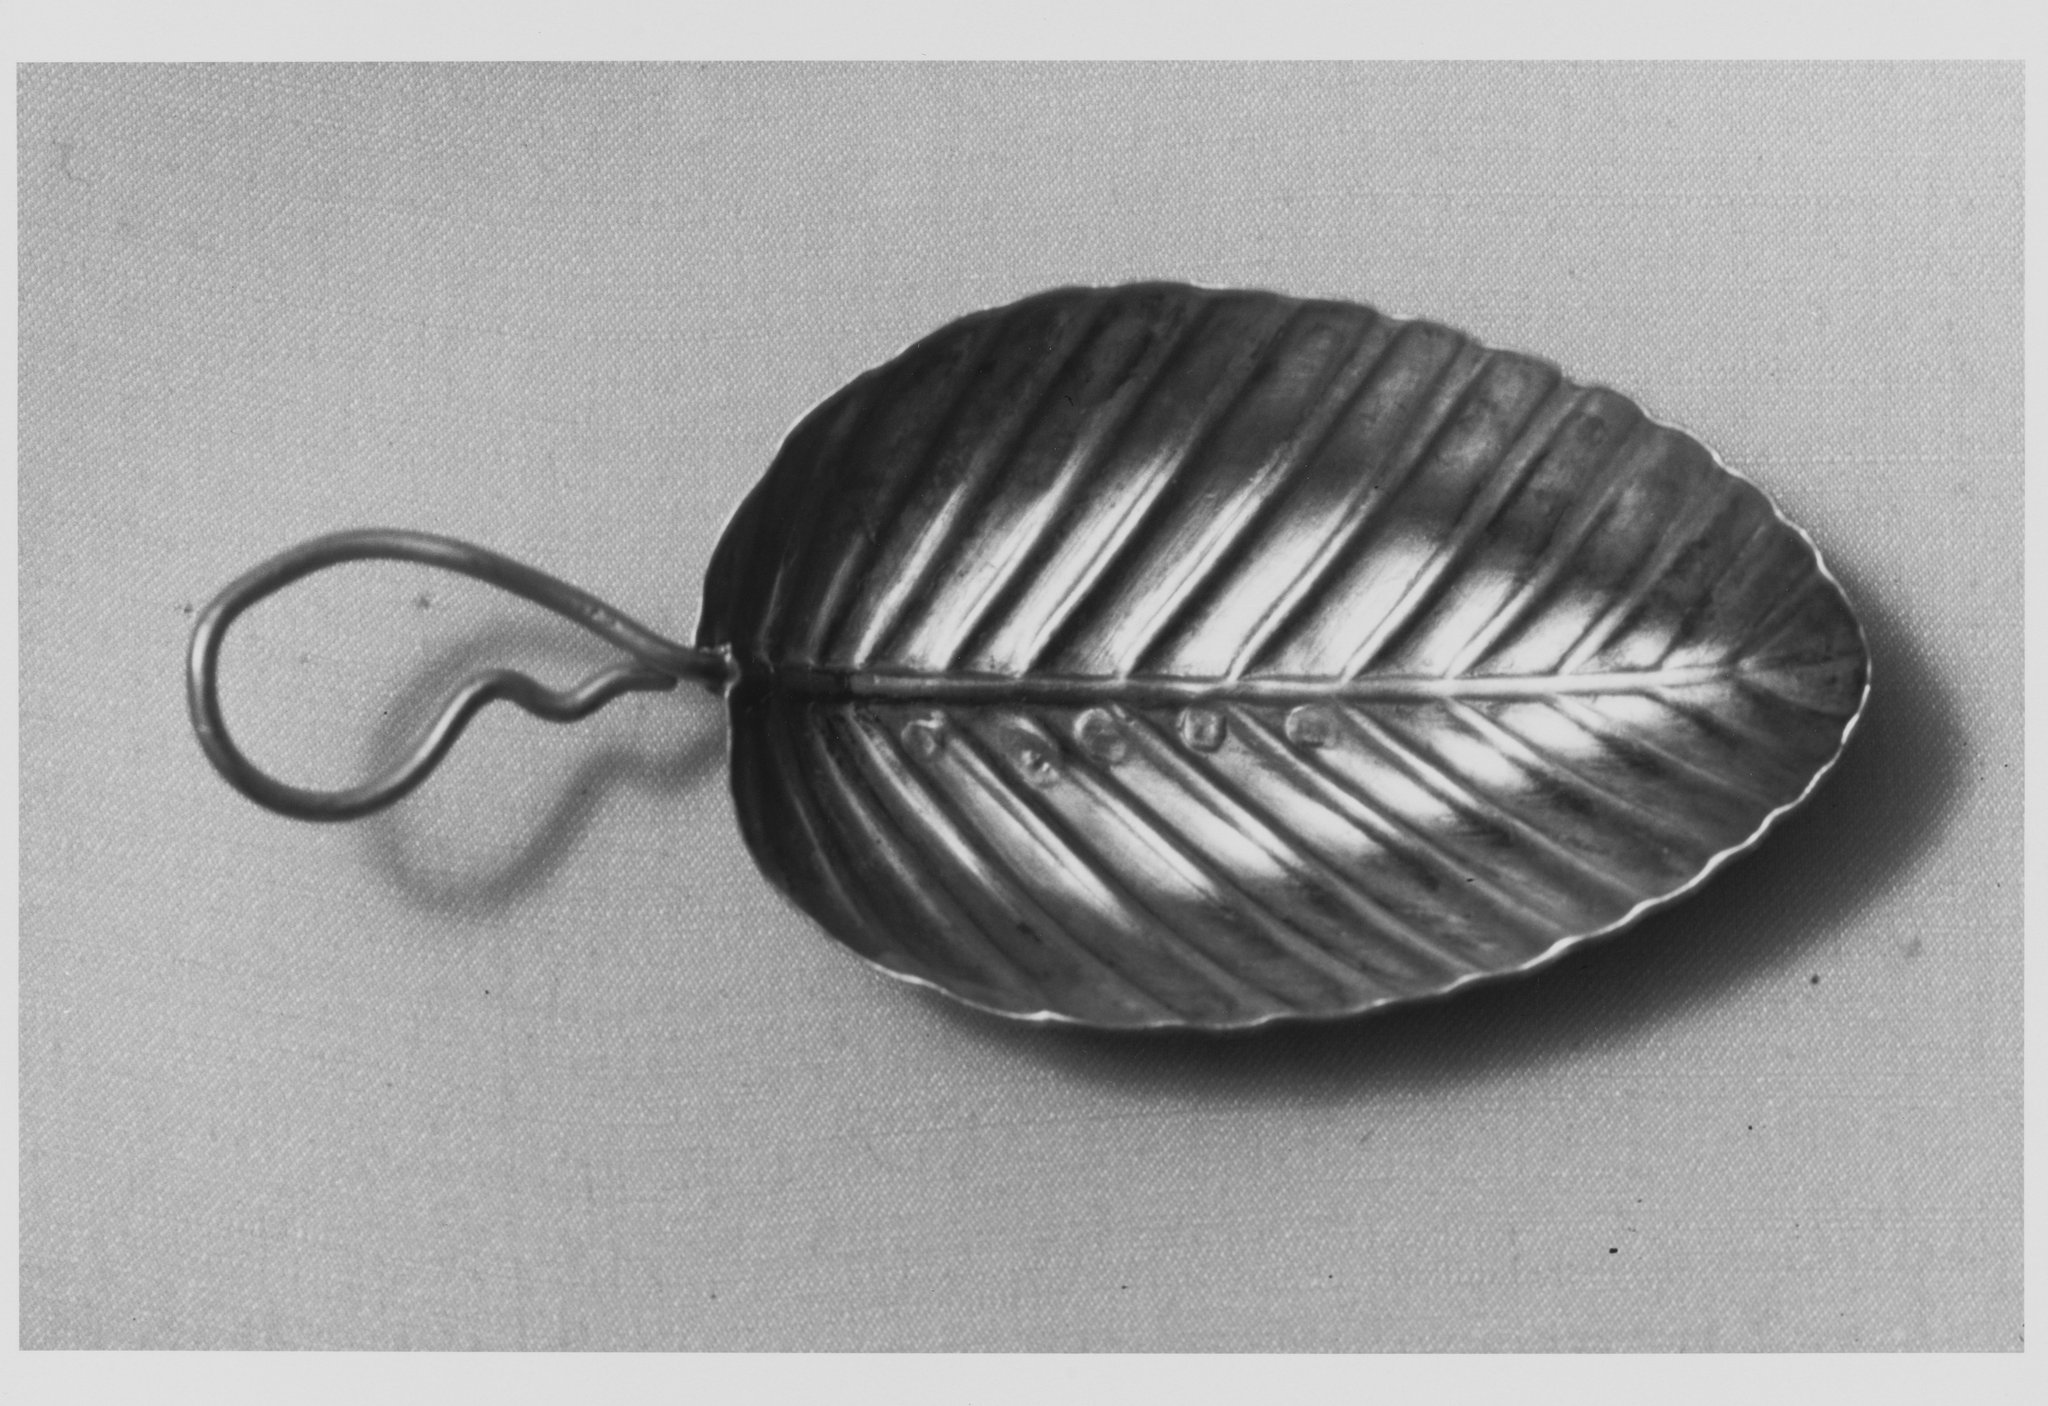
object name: caddy spoon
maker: cocks & betteridge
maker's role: maker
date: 1800-1801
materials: silver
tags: leaves